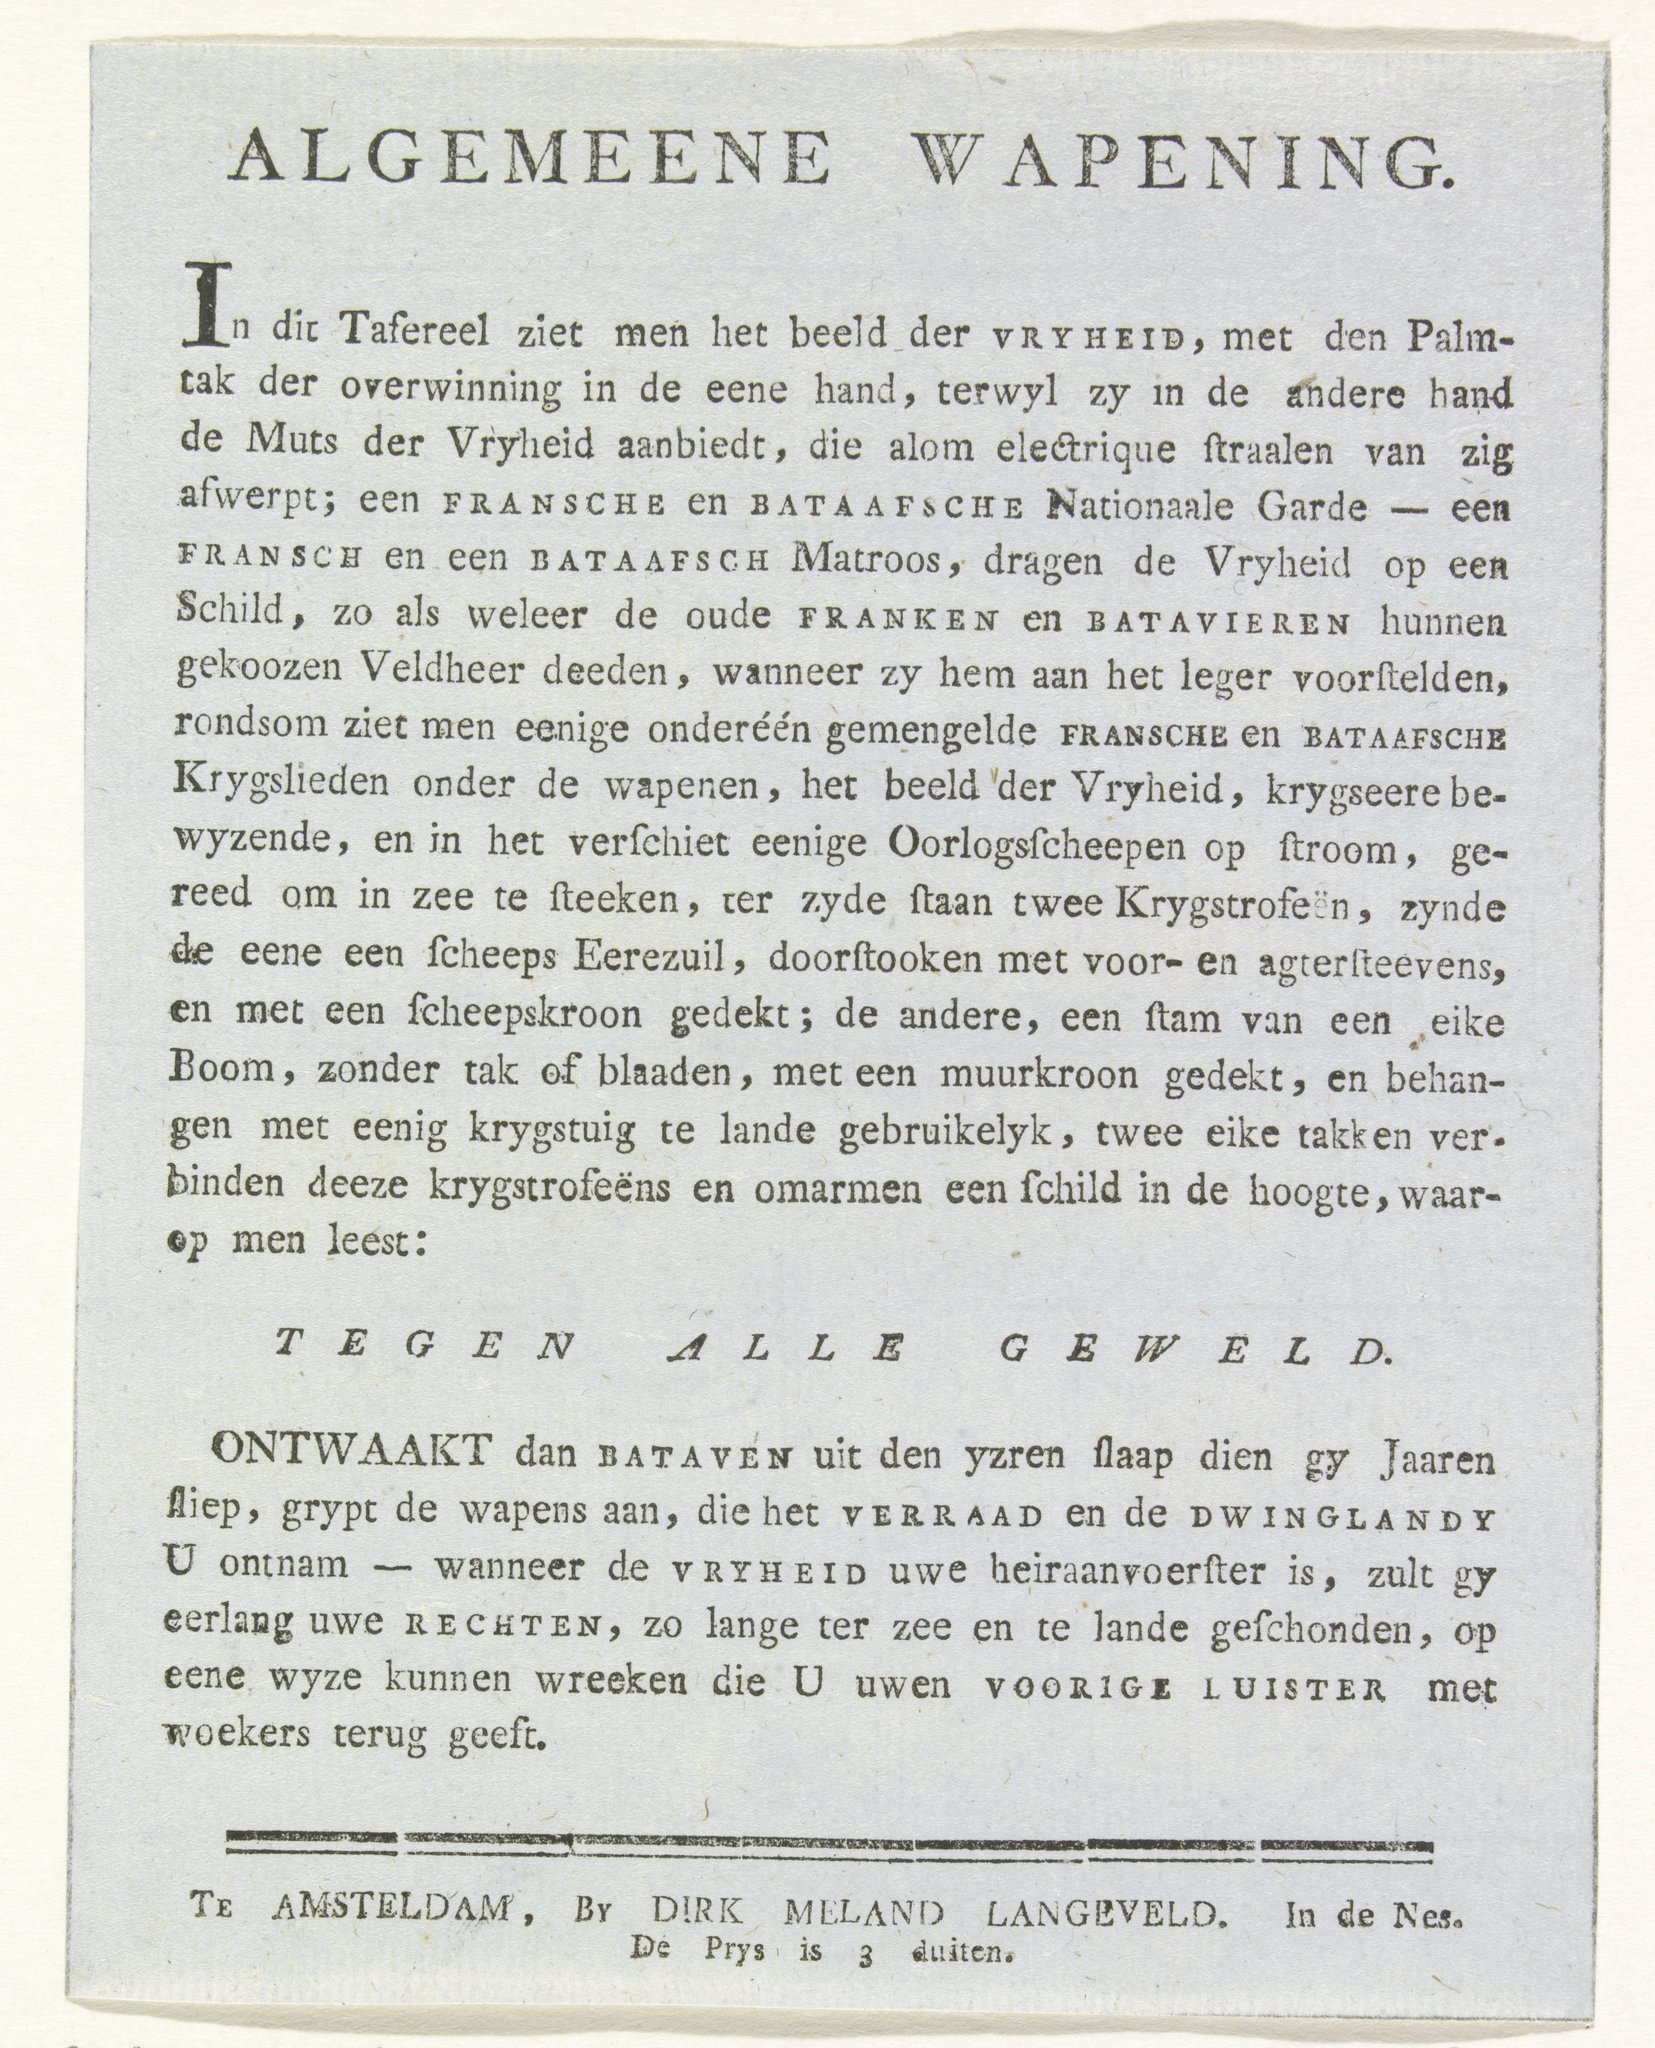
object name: text sheet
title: Algemeene Wapening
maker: dirk meland langeveld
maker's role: publisher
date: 1795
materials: paper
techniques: letterpress printing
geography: amsterdam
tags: amsterdam, alliance with france (1795)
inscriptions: collector's mark: Lugt 2228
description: Tekstblad met uitleg van de voorstellingen van Algemene Wapening, allegorische decoratie opgericht op het Kadijksplein te Amsterdam. Waarschijnlijk behorend bij een afzonderlijke uitgave van de losse platen van de versieringen opgericht in de stad bij de viering van de installatie van de representanten en de alliantie gesloten tussen de Franse en de Bataafse Republiek, 19 juni 1795.